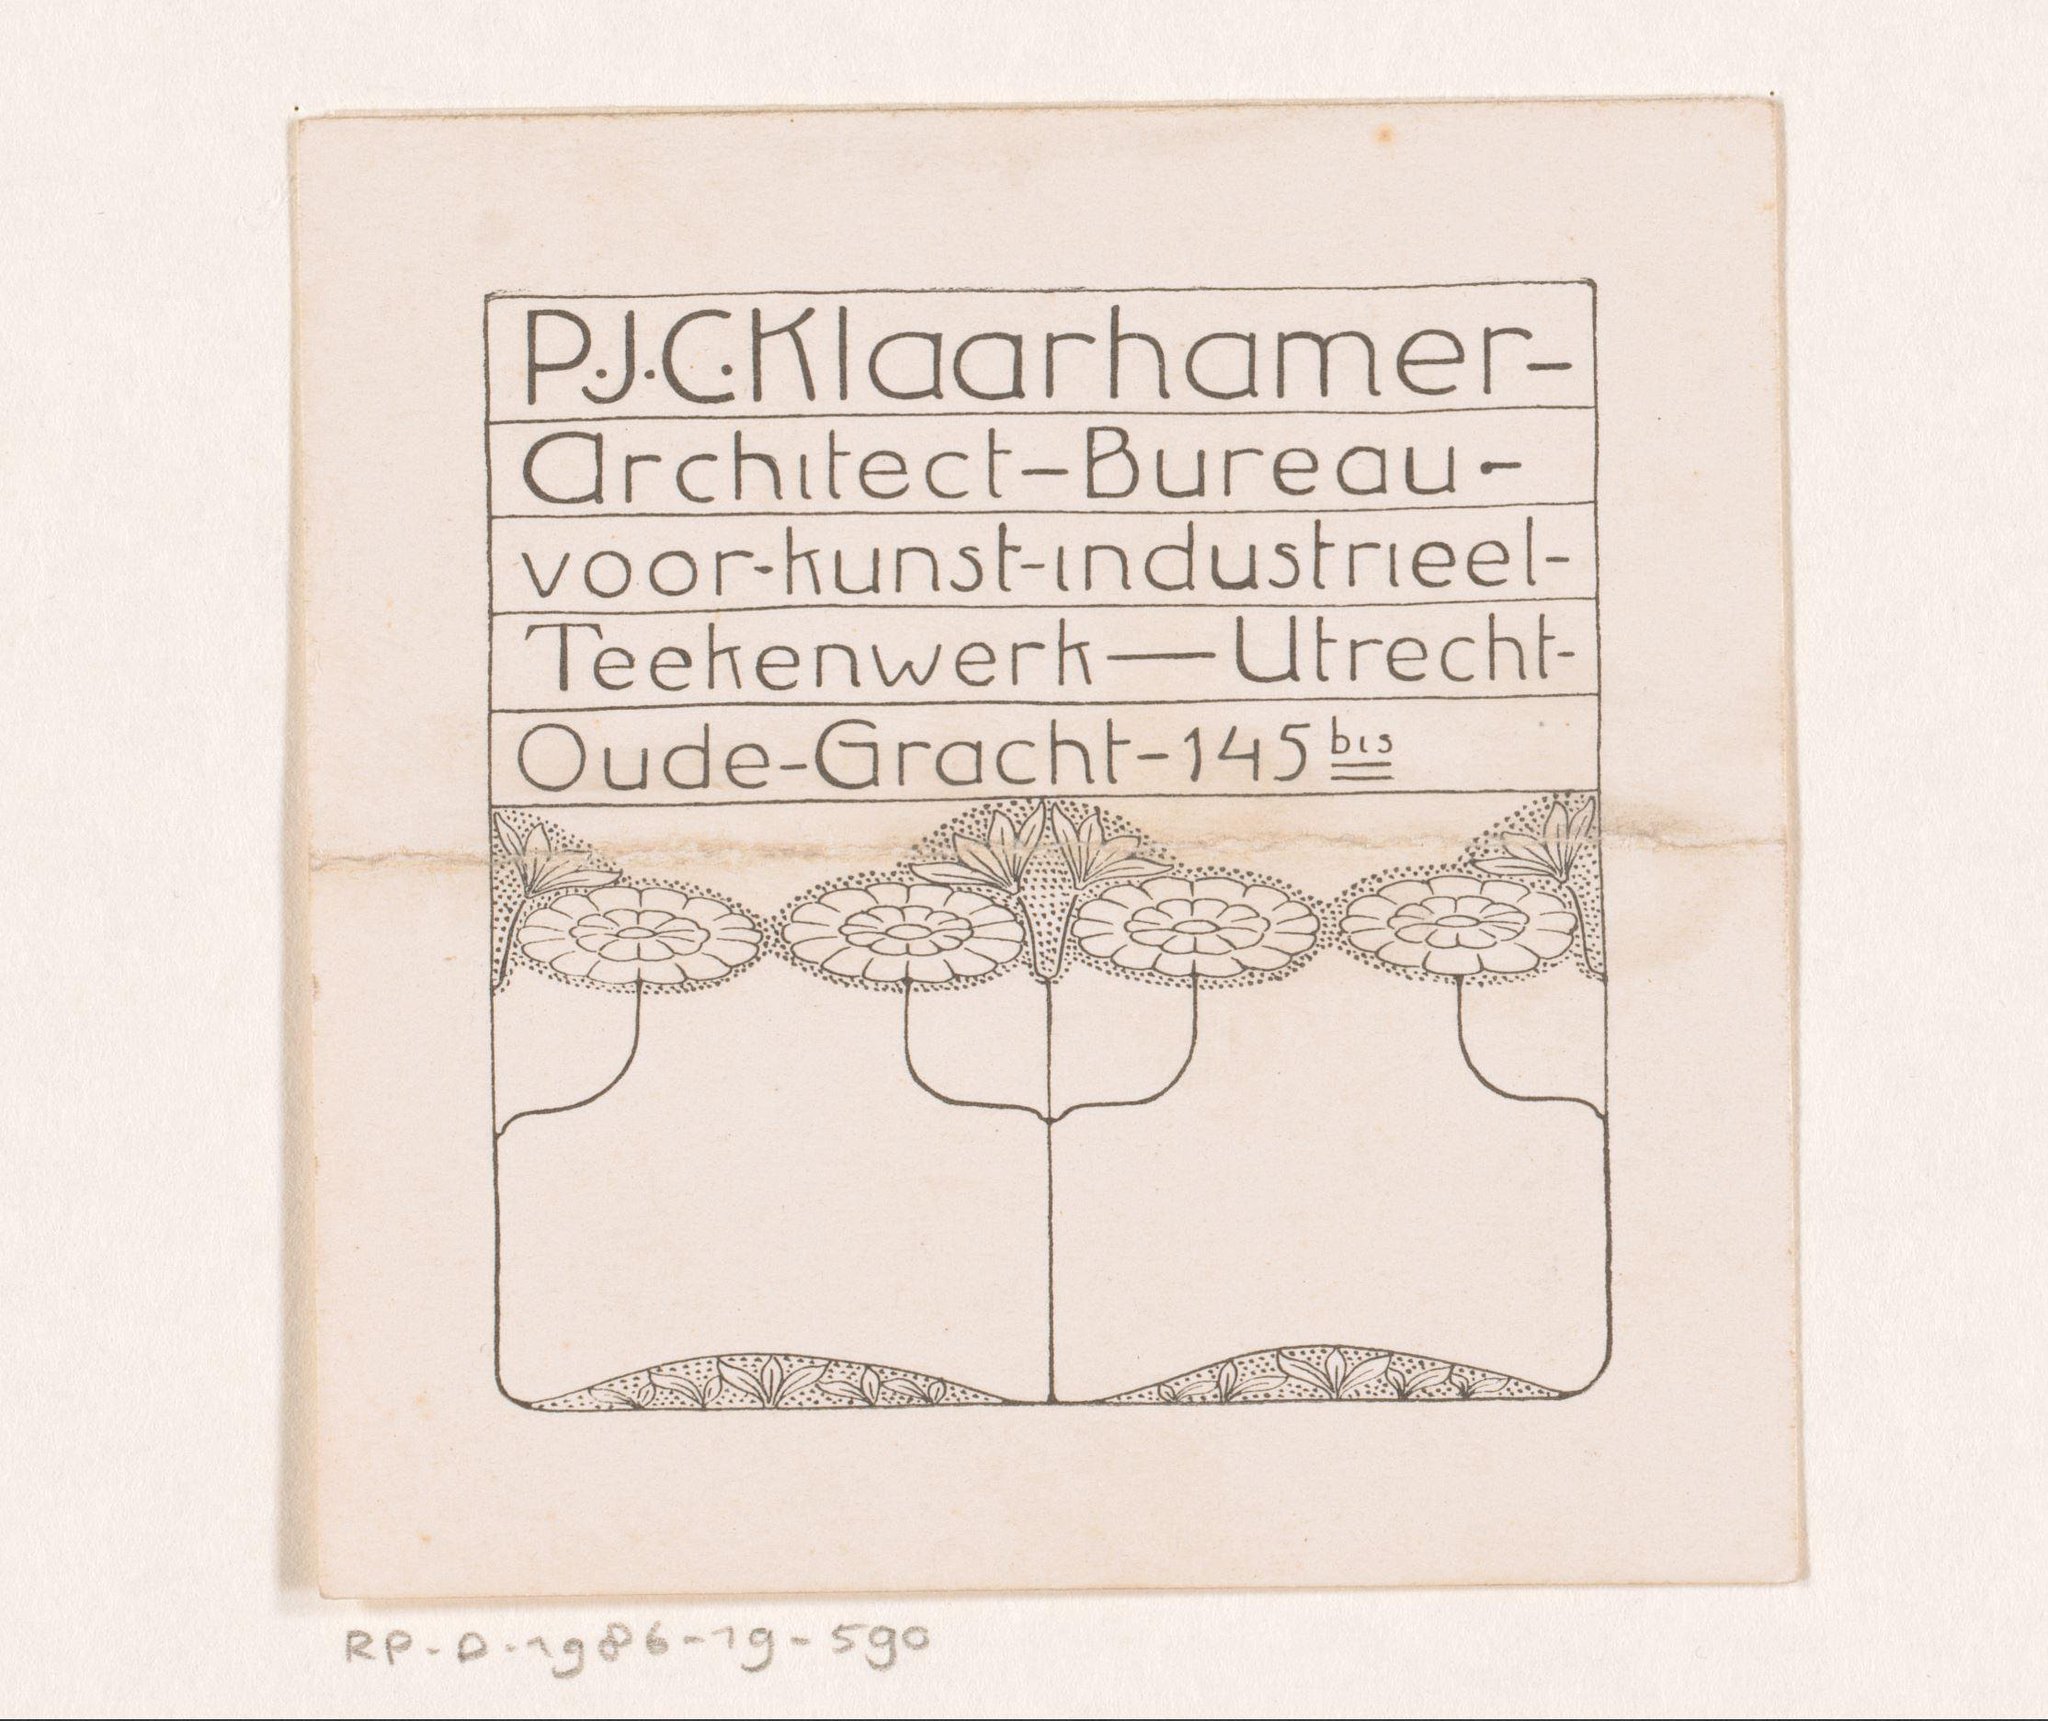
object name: photomechanical print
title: Advertentie van P.J.C. Klaarhamer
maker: Anonymous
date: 1884-1954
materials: paper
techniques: printing block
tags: pieter jan christoffel klaarhamer, flowers ~ ornament - aa - stylized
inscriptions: annotation: ‘Amice (...) wederdienst’, collector's mark: ‘R:MVS.’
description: Advertentie met een patroon van bloemen.